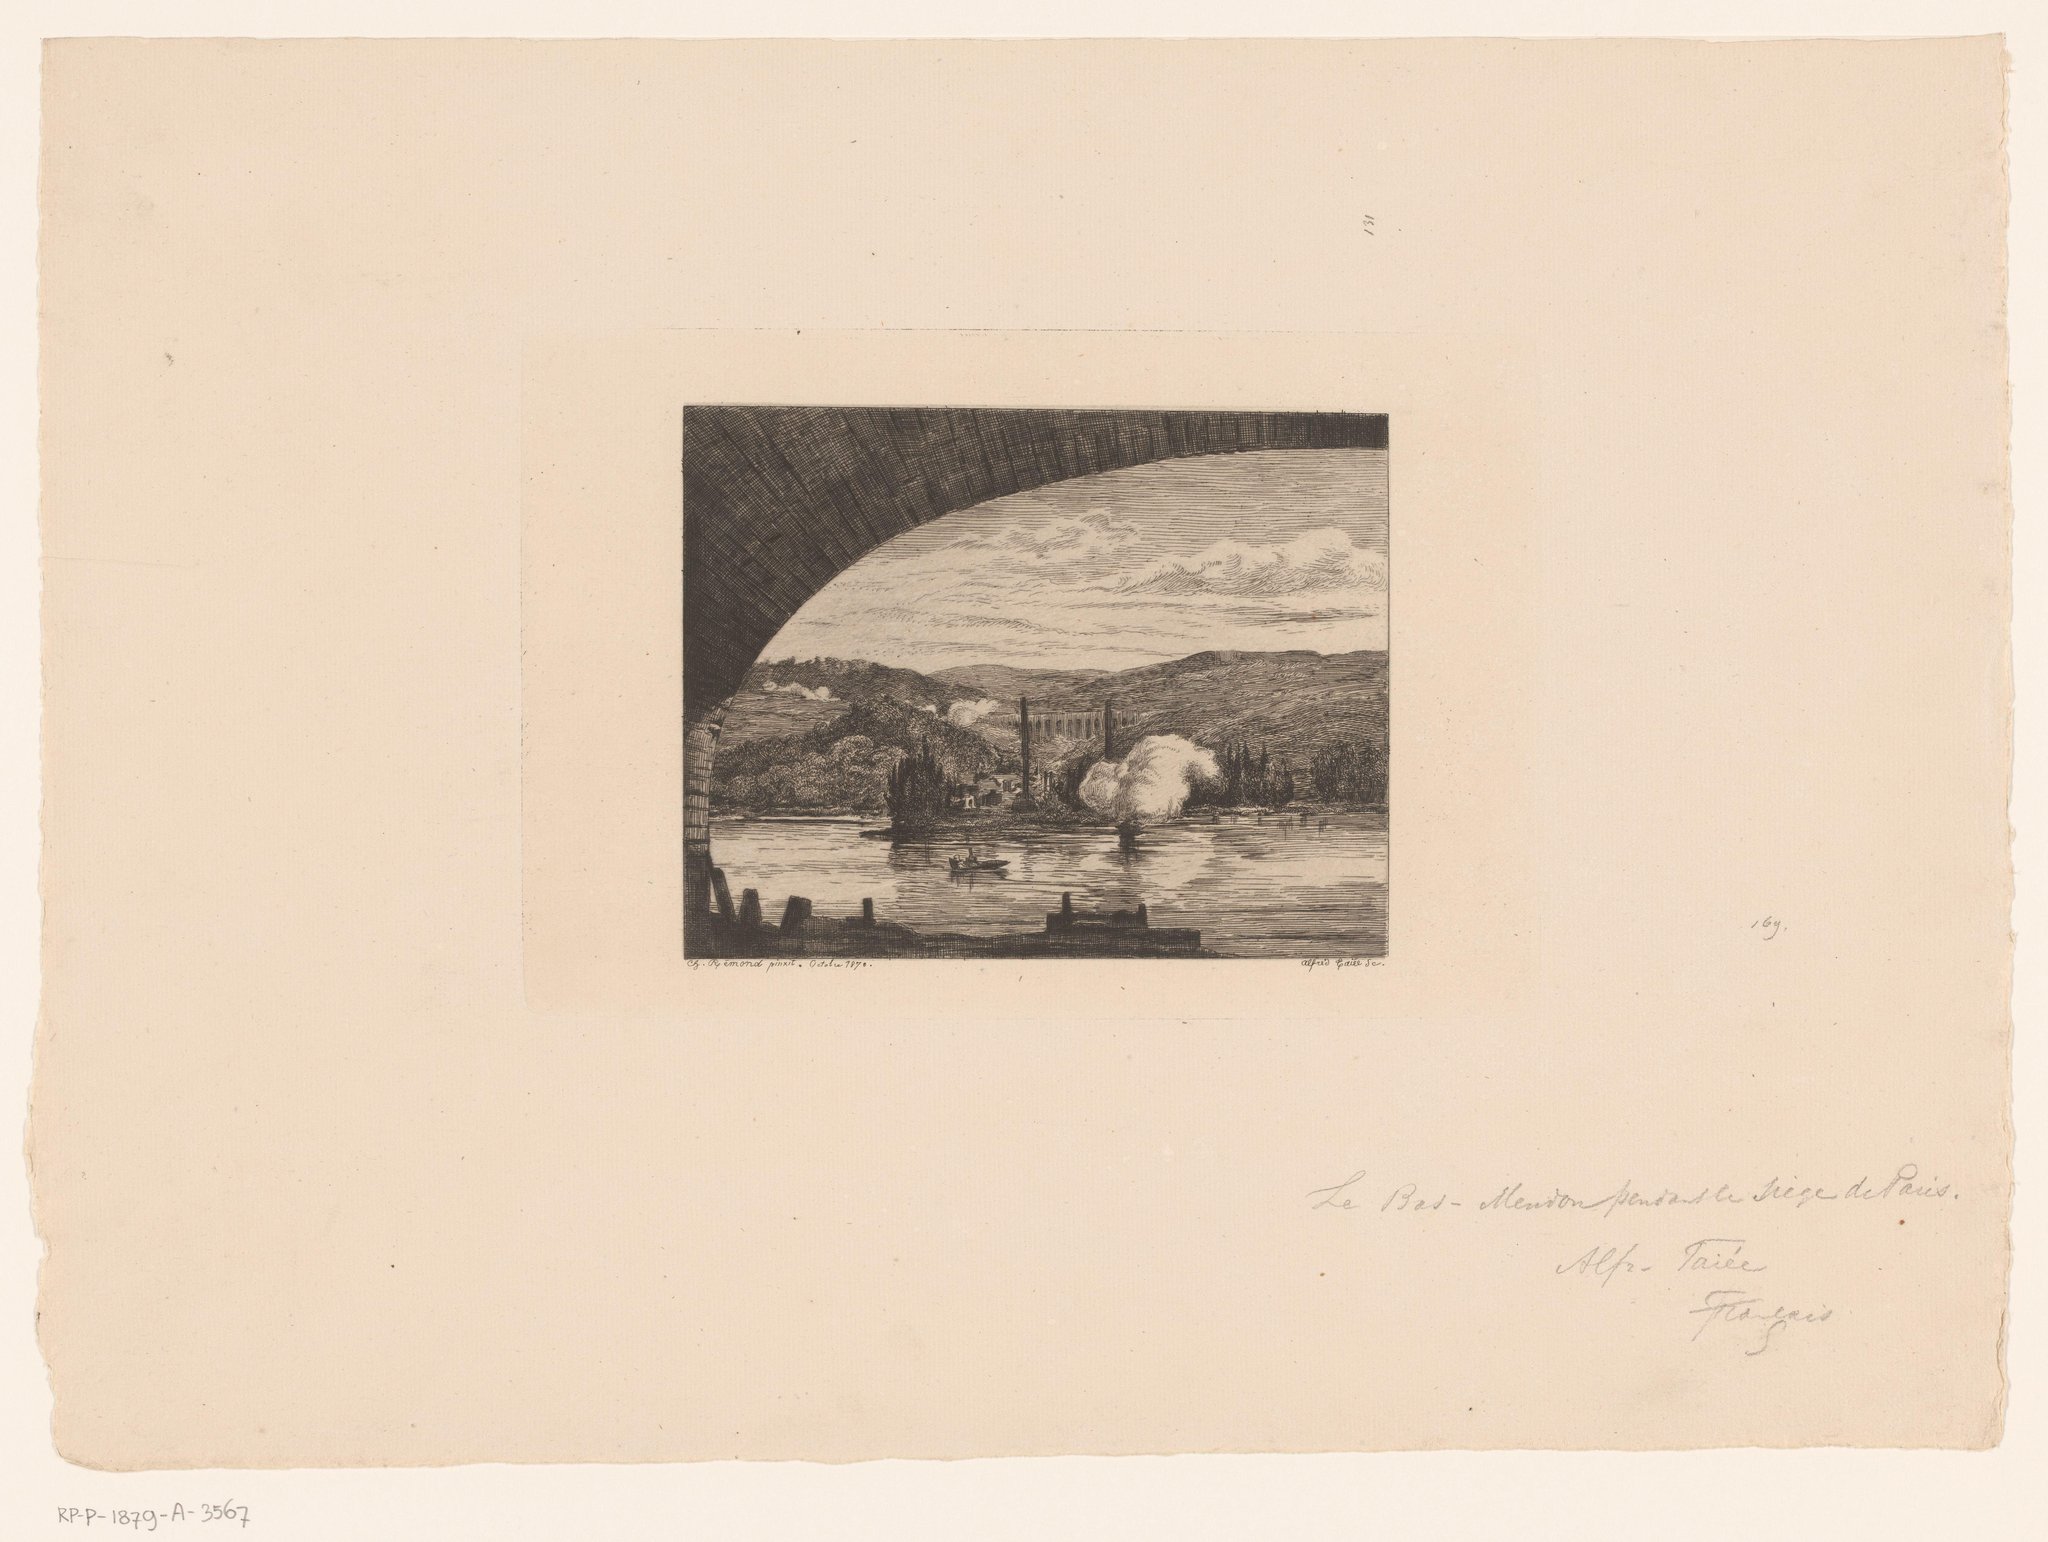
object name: print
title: Le Bas Meudon gedurende het beleg van Parijs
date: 1810-1870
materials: paper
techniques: etching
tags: landscapes, war, paris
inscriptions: collector's mark: Lugt 2228